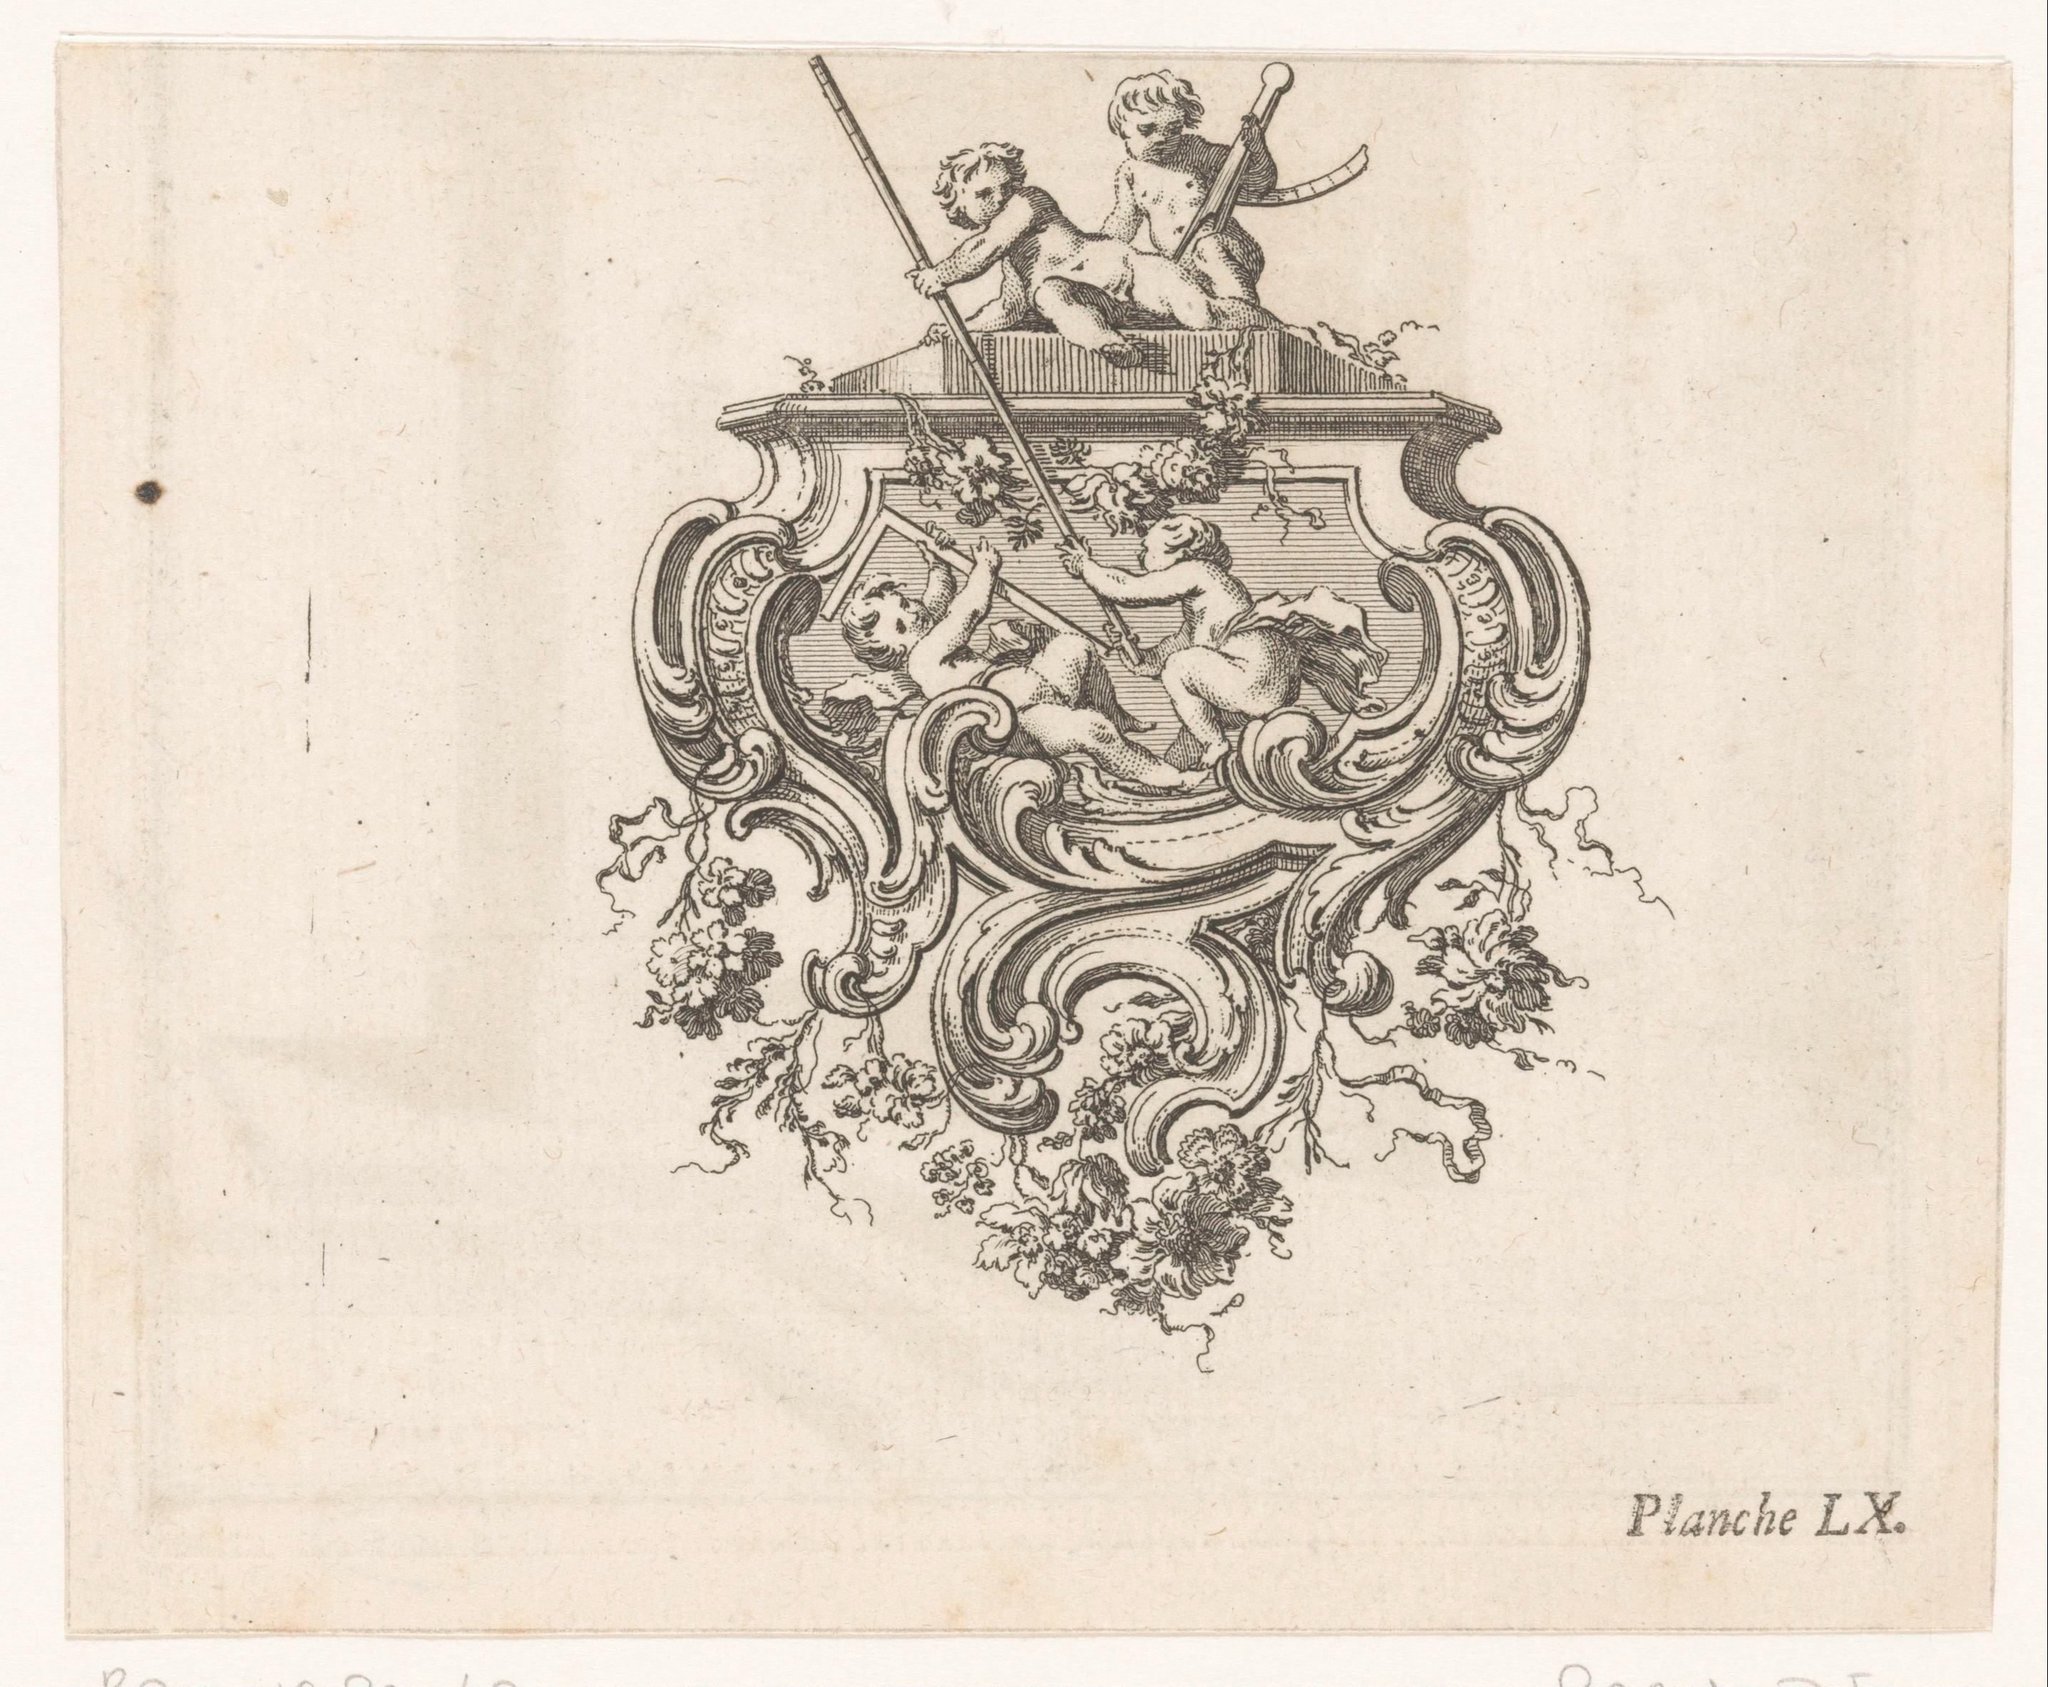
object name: print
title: Vignet met vier putti in een cartouche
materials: paper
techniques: etching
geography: paris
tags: measuring-instruments, ornament ~ cartouche, cupids: 'amores', 'amoretti', 'putti'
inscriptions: collector's mark: Lugt 2228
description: Prent uit: Edme-Sébastien. Traité de perspective à l'usage des artistes (...). Parijs: Jombert, Charles Antoine, 1750.